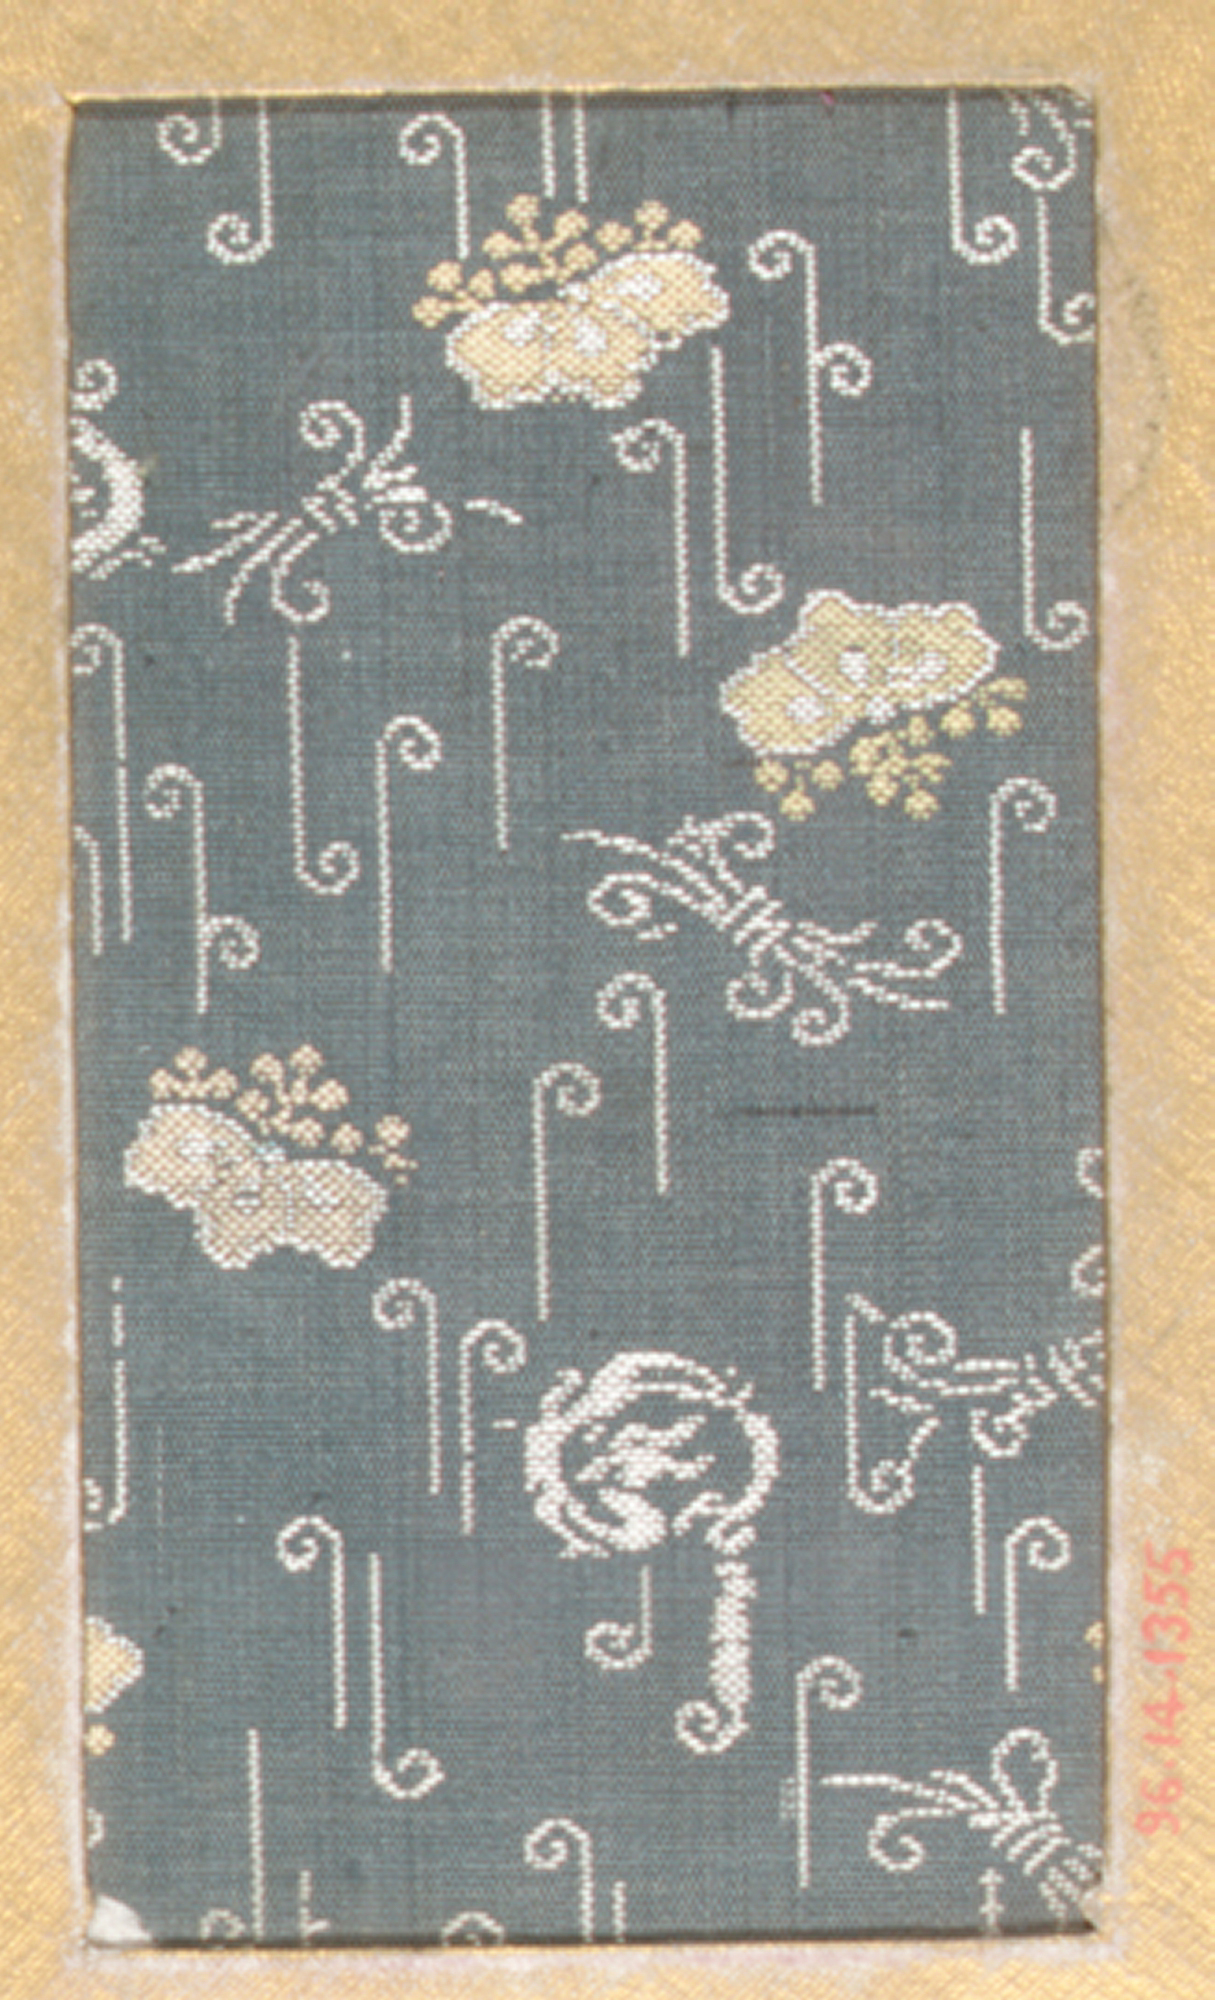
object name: piece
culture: japanese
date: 1701-1900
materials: silk